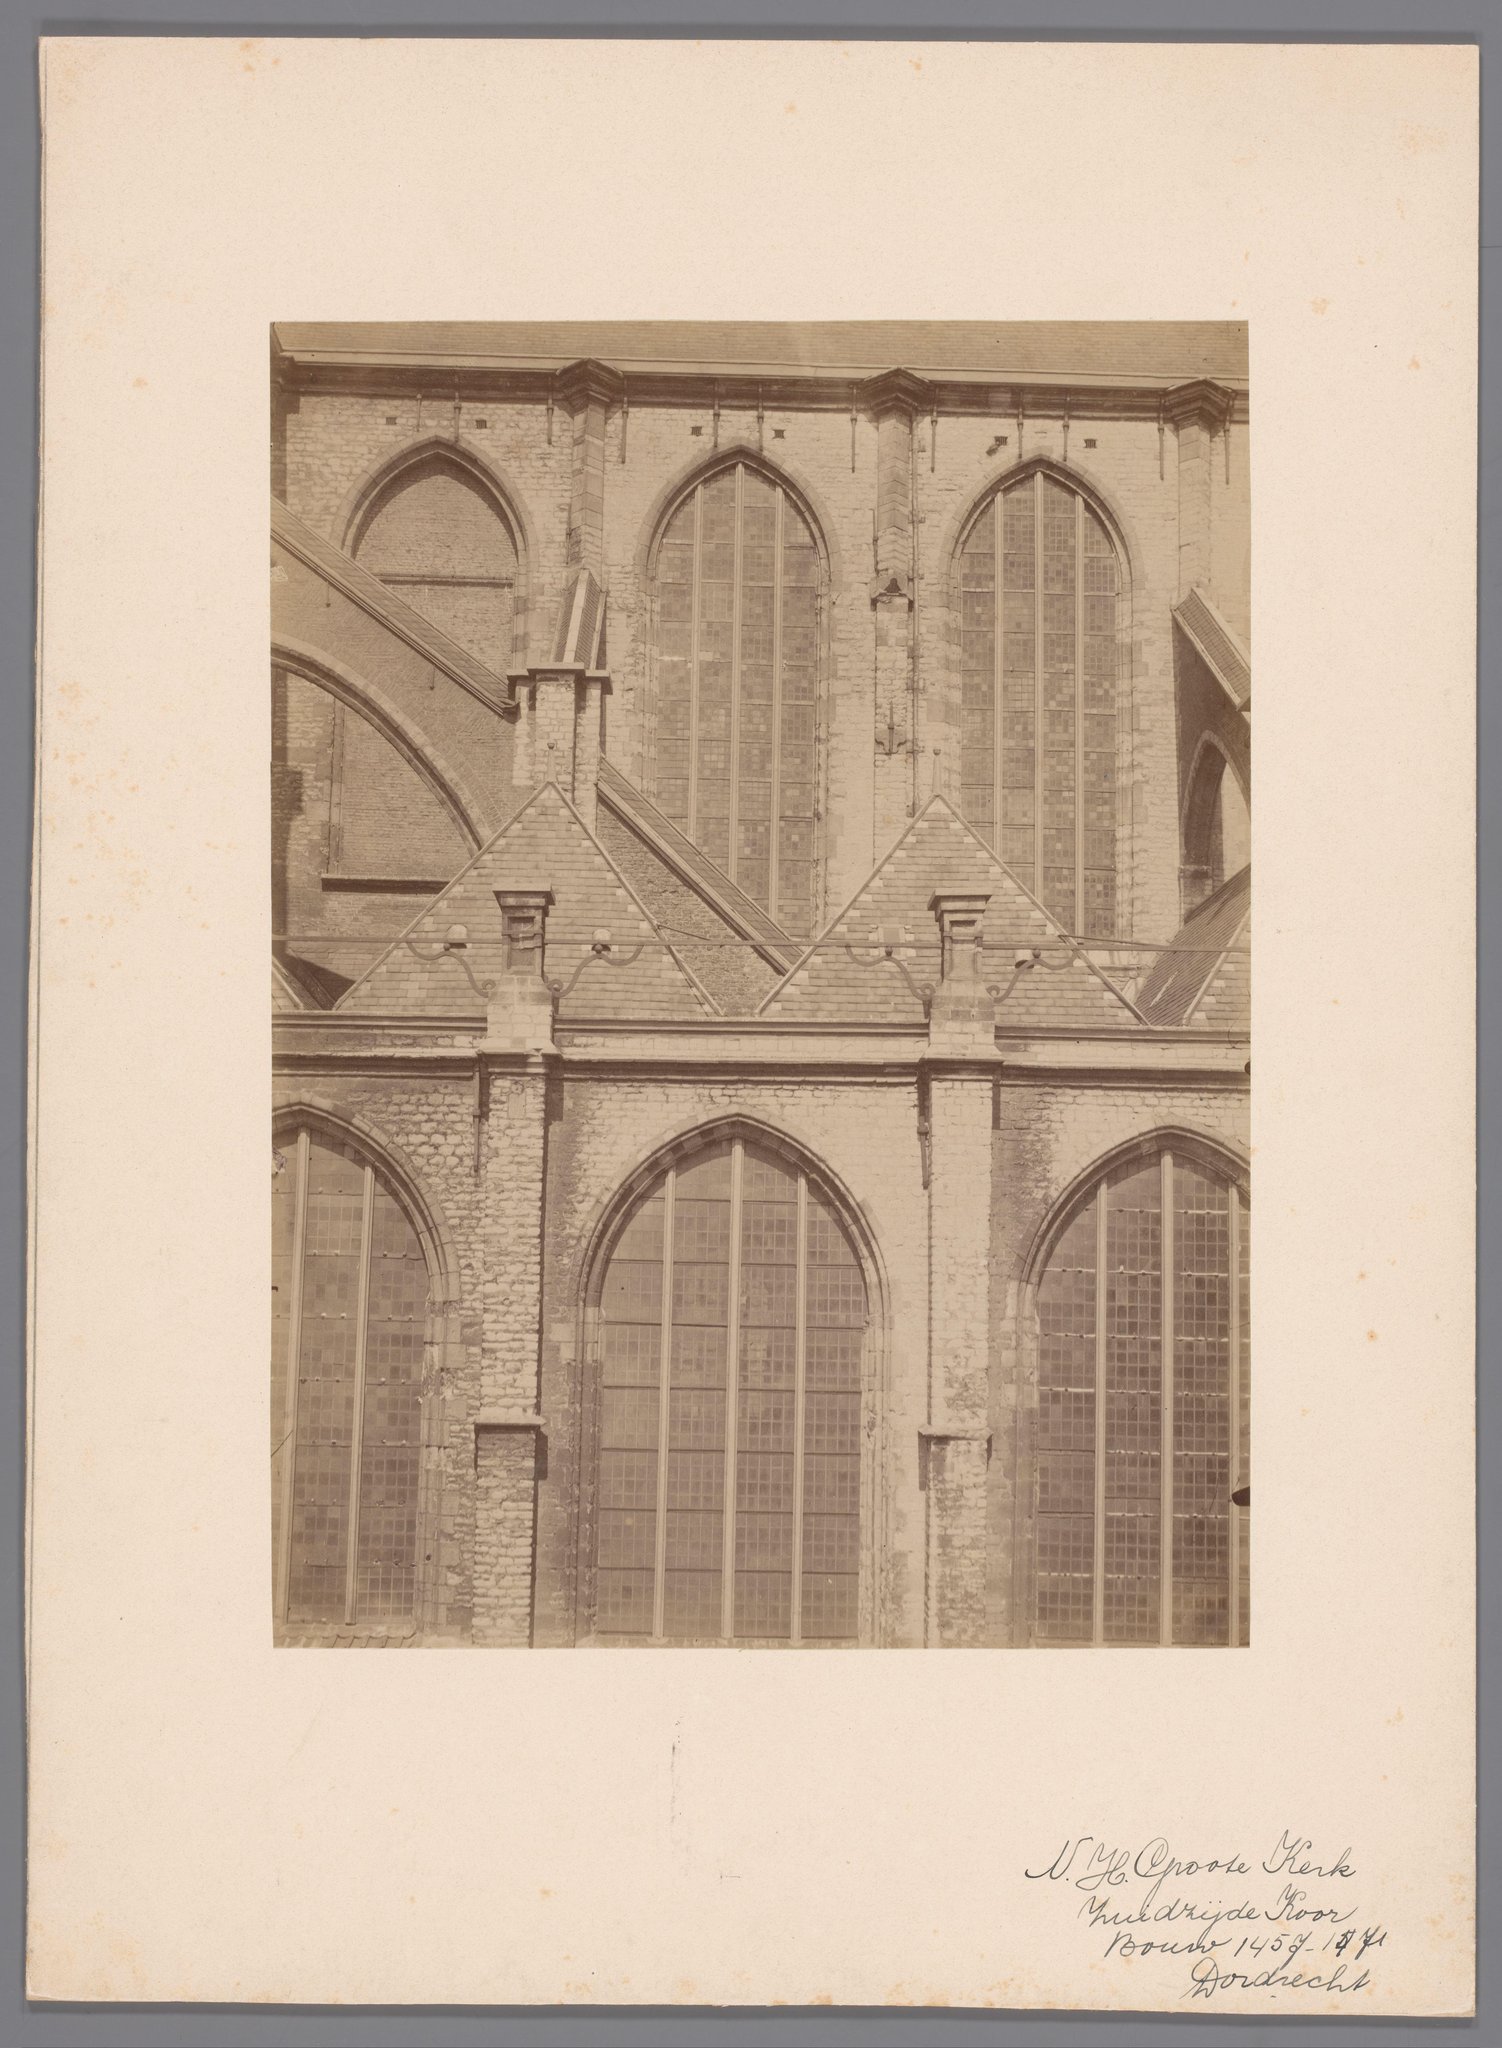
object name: photograph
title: Detail van het koor van de Grote of Onze-Lieve-Vrouwenkerk te Dordrecht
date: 1880-1910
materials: cardboard, photographic support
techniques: albumen print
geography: dordrecht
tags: church (exterior)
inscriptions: annotation: ‘Dordrecht/ Zuidzijde koor/ Bouw 1457-1471’, annotation: ‘N.H. Groote Kerk/ Zuidzijde Koor/ Bouw 1457-1471/ Dordrecht’